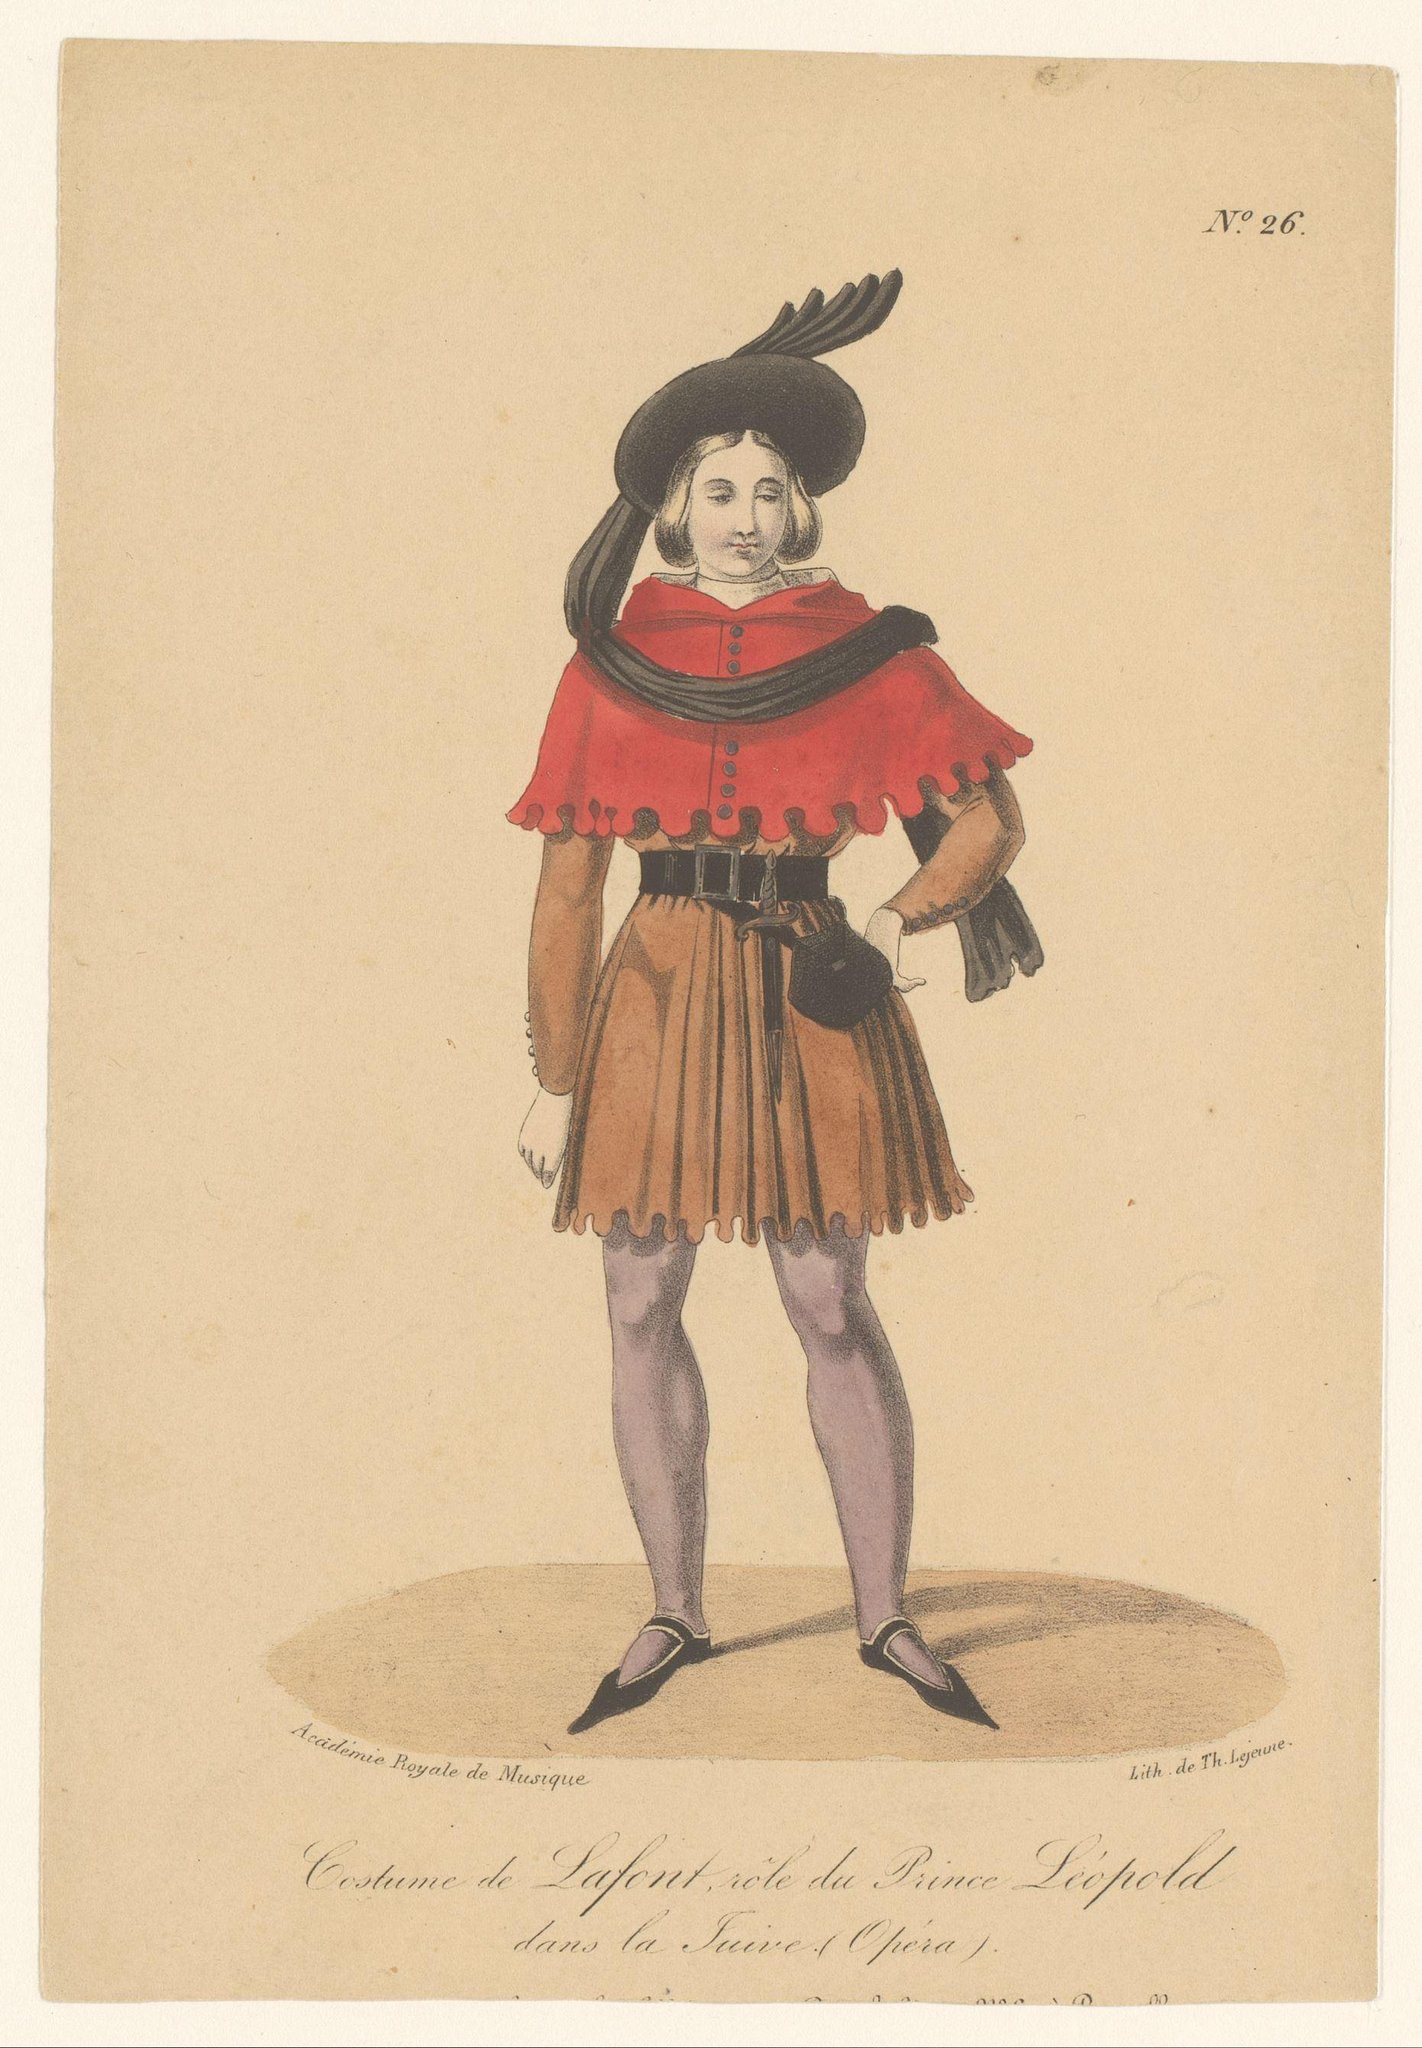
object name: print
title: Acteurs, actrices en operazangers in hun rol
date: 1835-1850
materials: paper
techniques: hand coloring, lithograph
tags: historical persons, historical costume, portrait of actor, actress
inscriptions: collector's mark: Lugt 2228